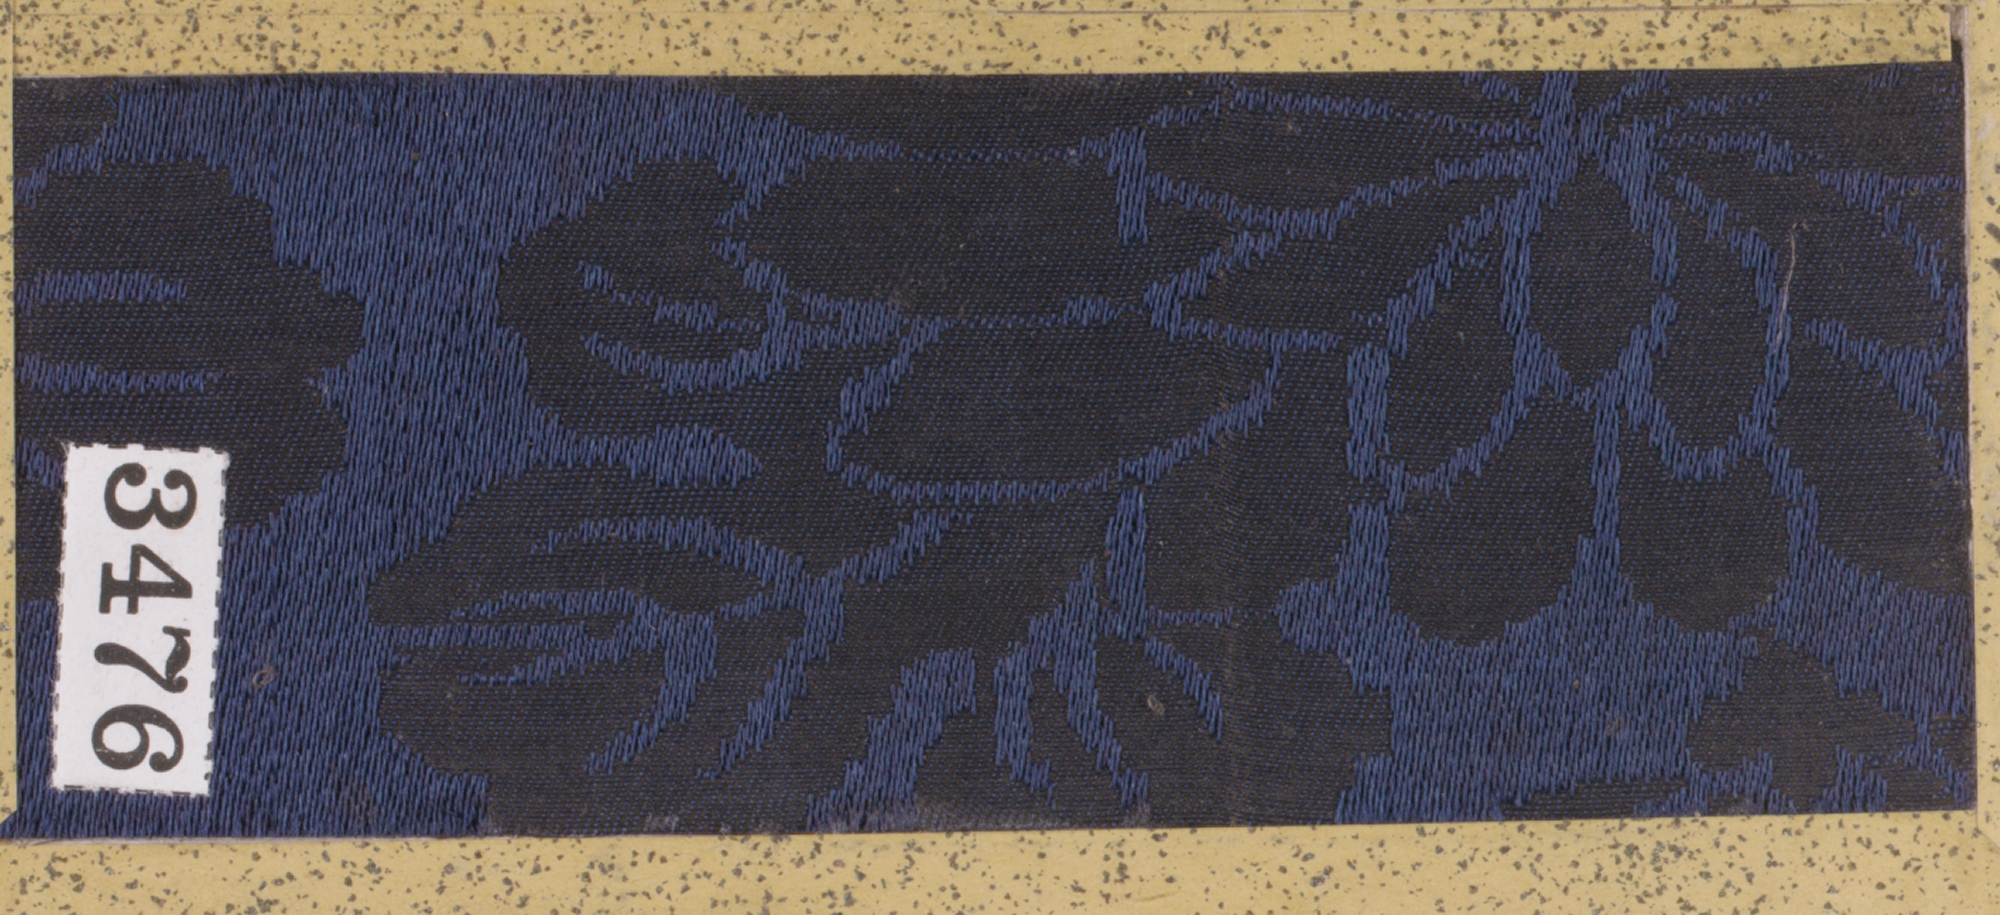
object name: sample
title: Textile Sample from Sample Book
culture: japanese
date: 1801-1900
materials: silk